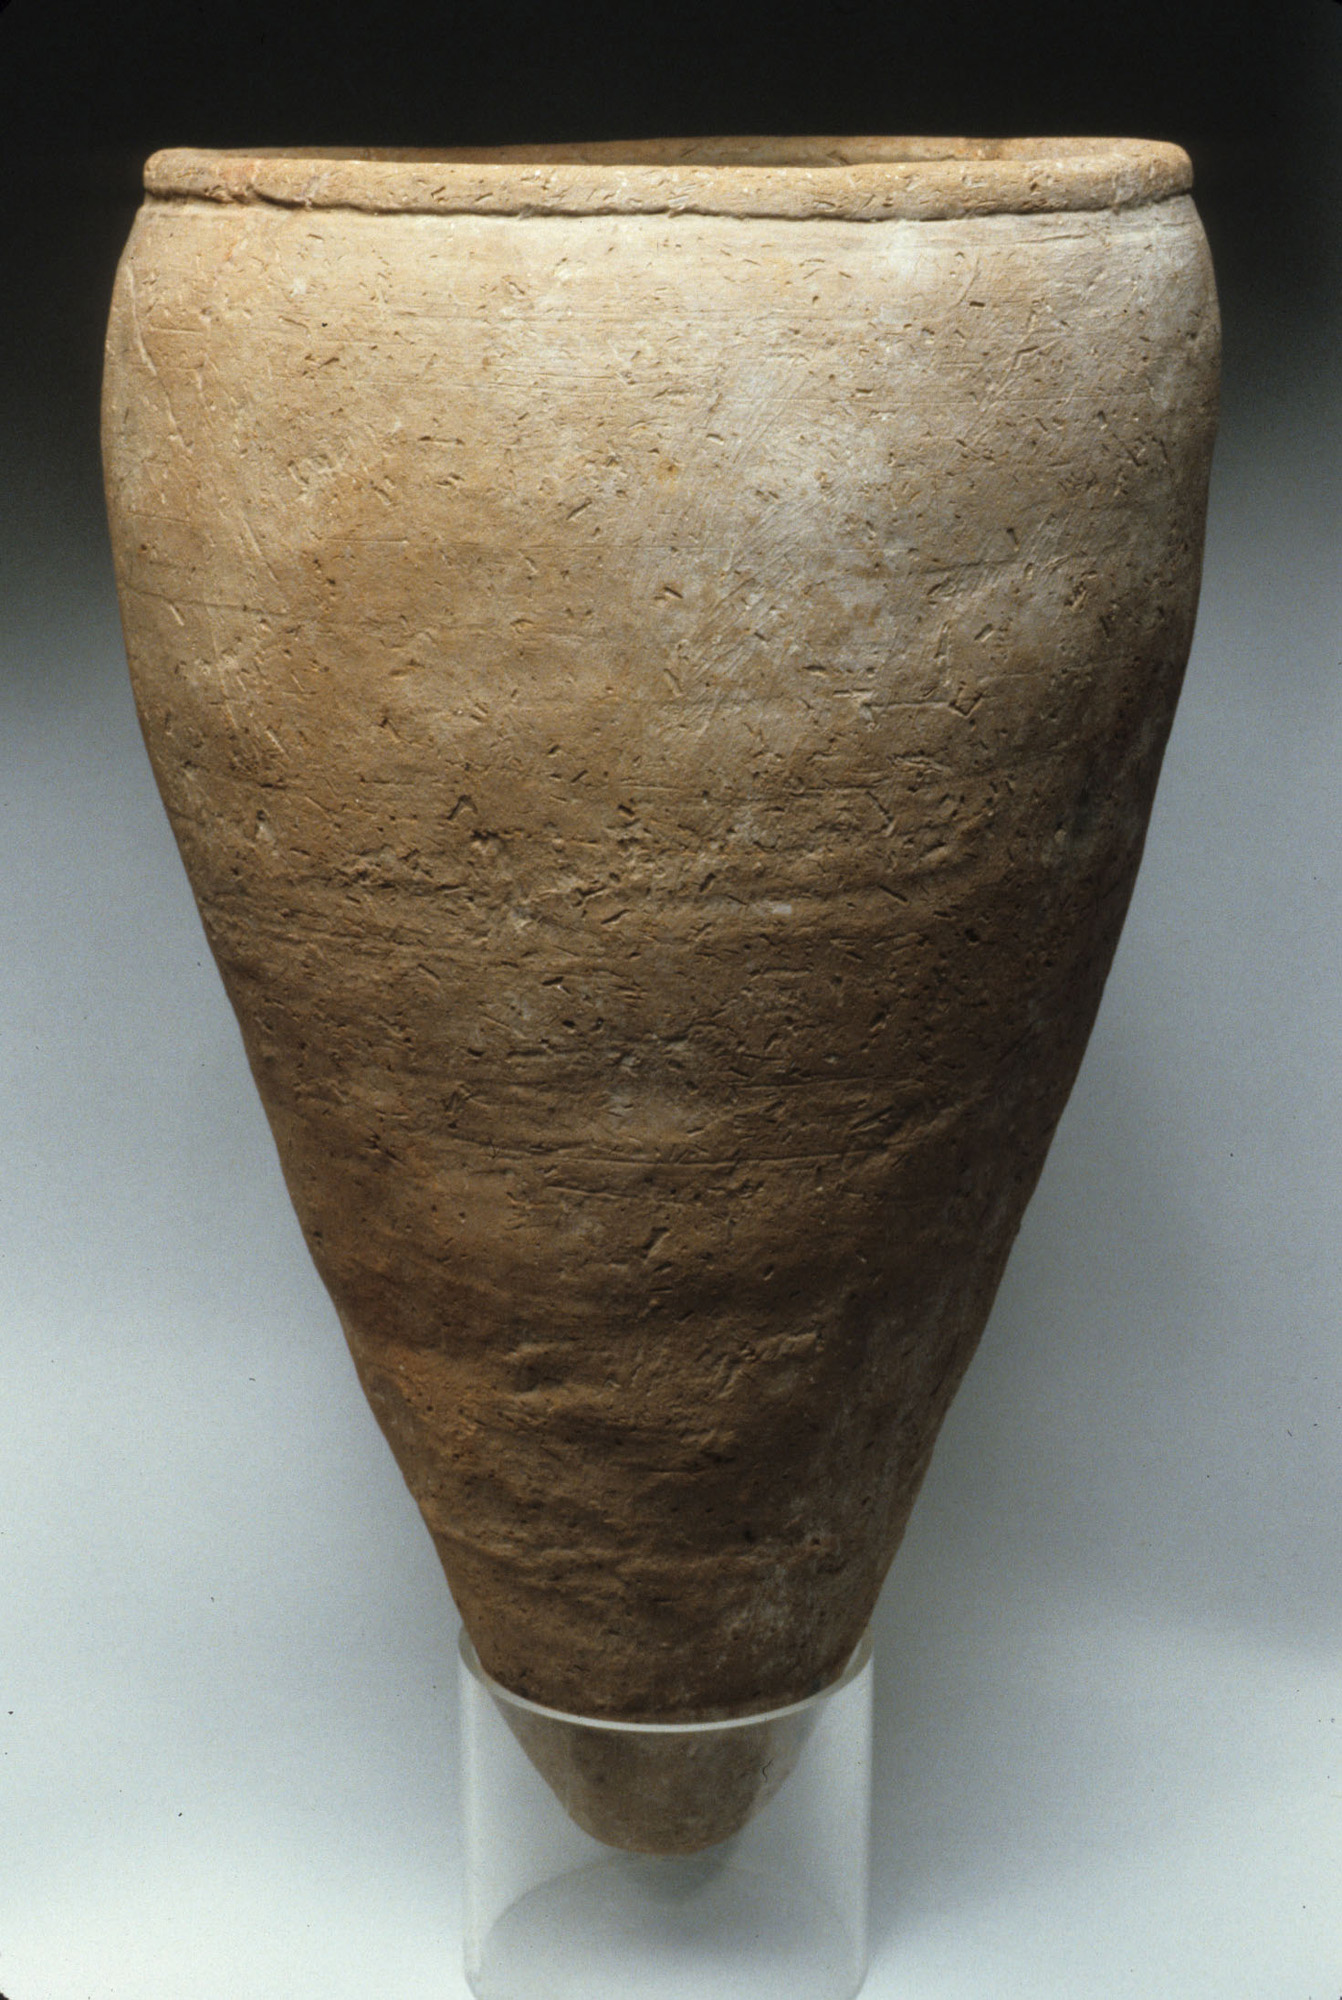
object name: jar, rough ware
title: Rough ware storage jar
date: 3500-3300 BCE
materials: pottery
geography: egypt